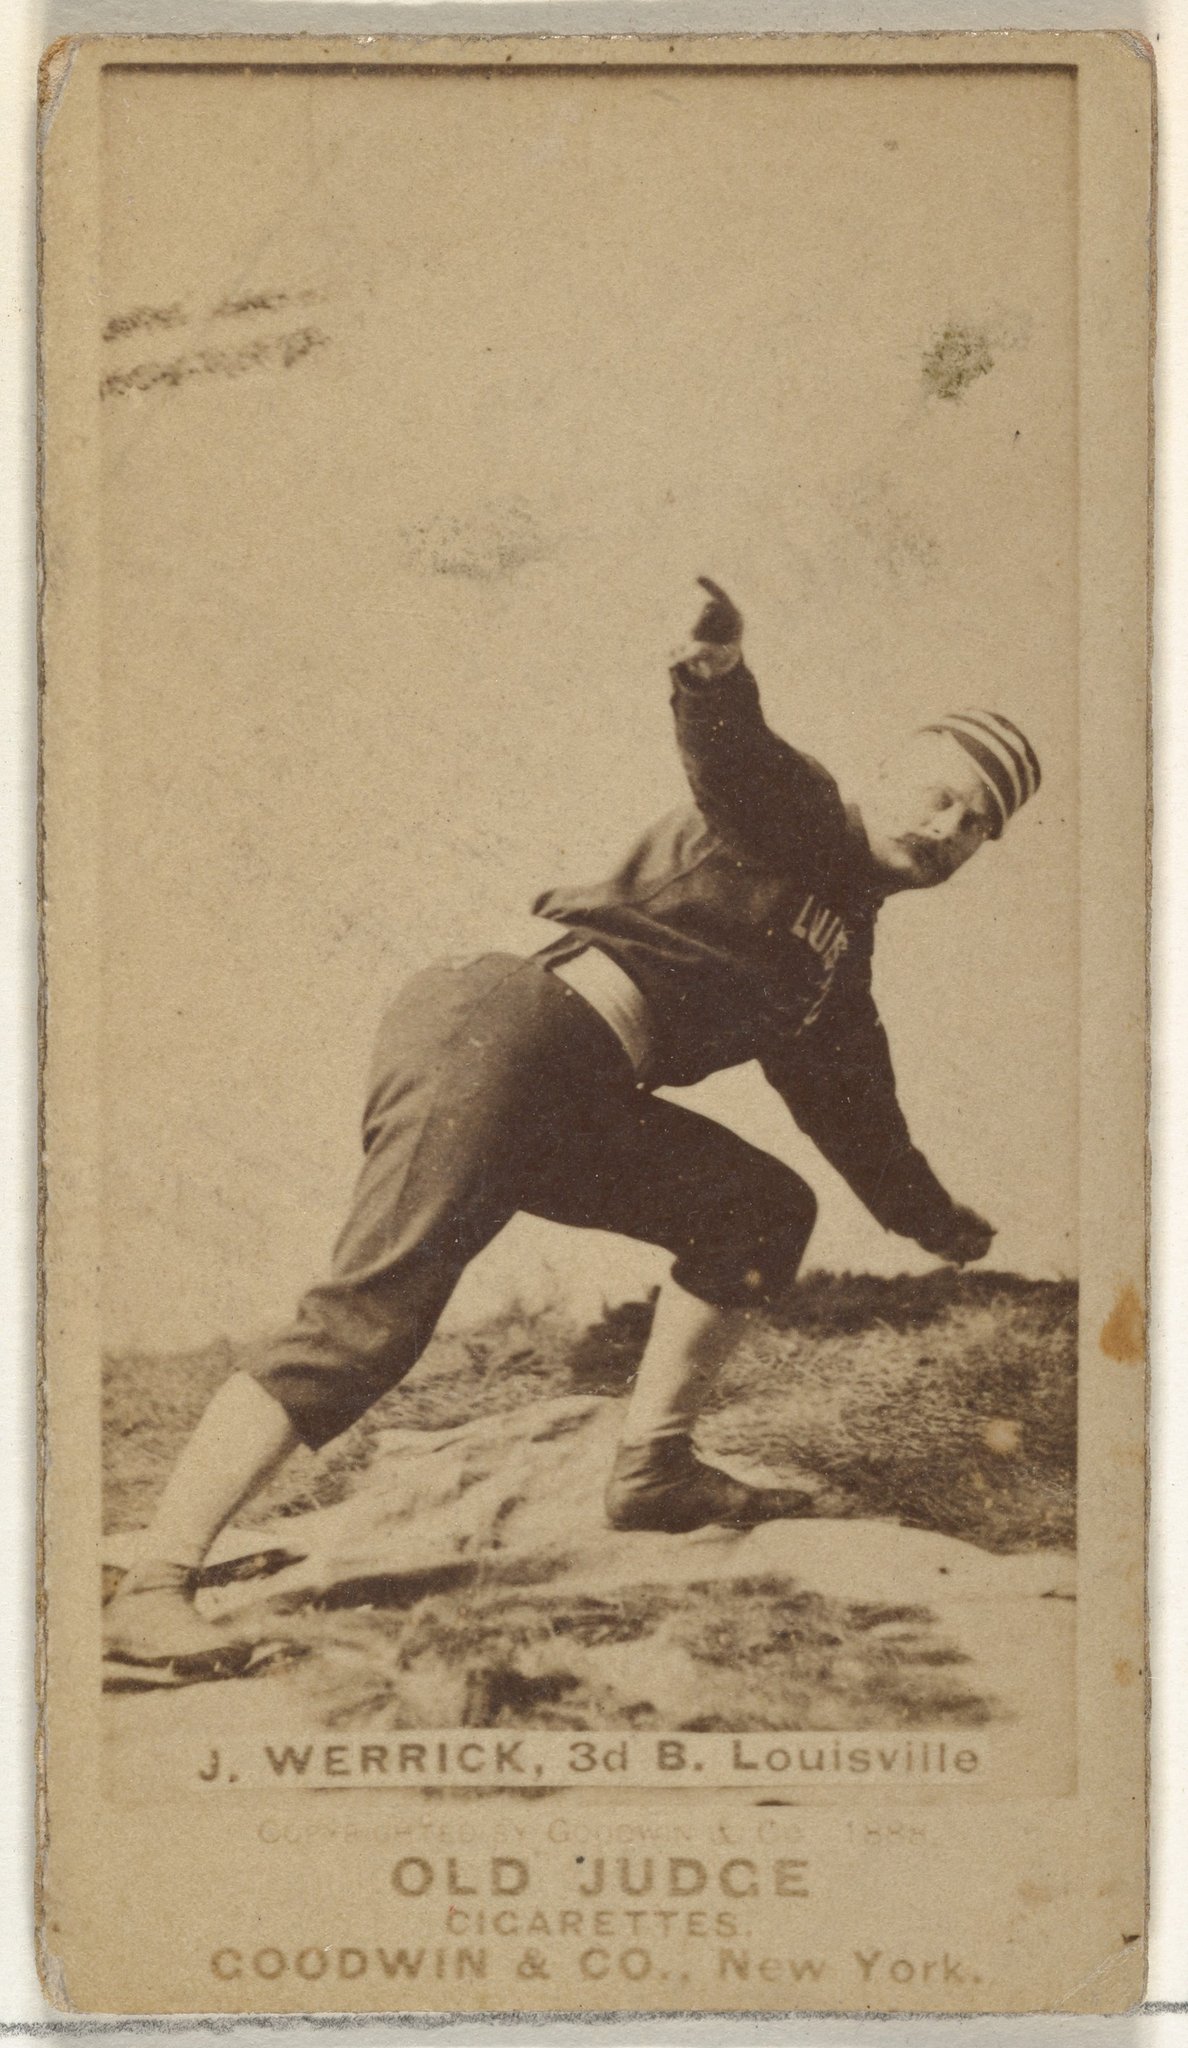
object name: baseball card, photograph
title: Joseph Abraham "Joe" Werrick, 3rd Base, Louisville Colonels, from the Old Judge series (N172) for Old Judge Cigarettes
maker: goodwin & company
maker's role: publisher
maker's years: 1850-1950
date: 1888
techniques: albumen silver print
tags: men,portraits,baseball,athletes